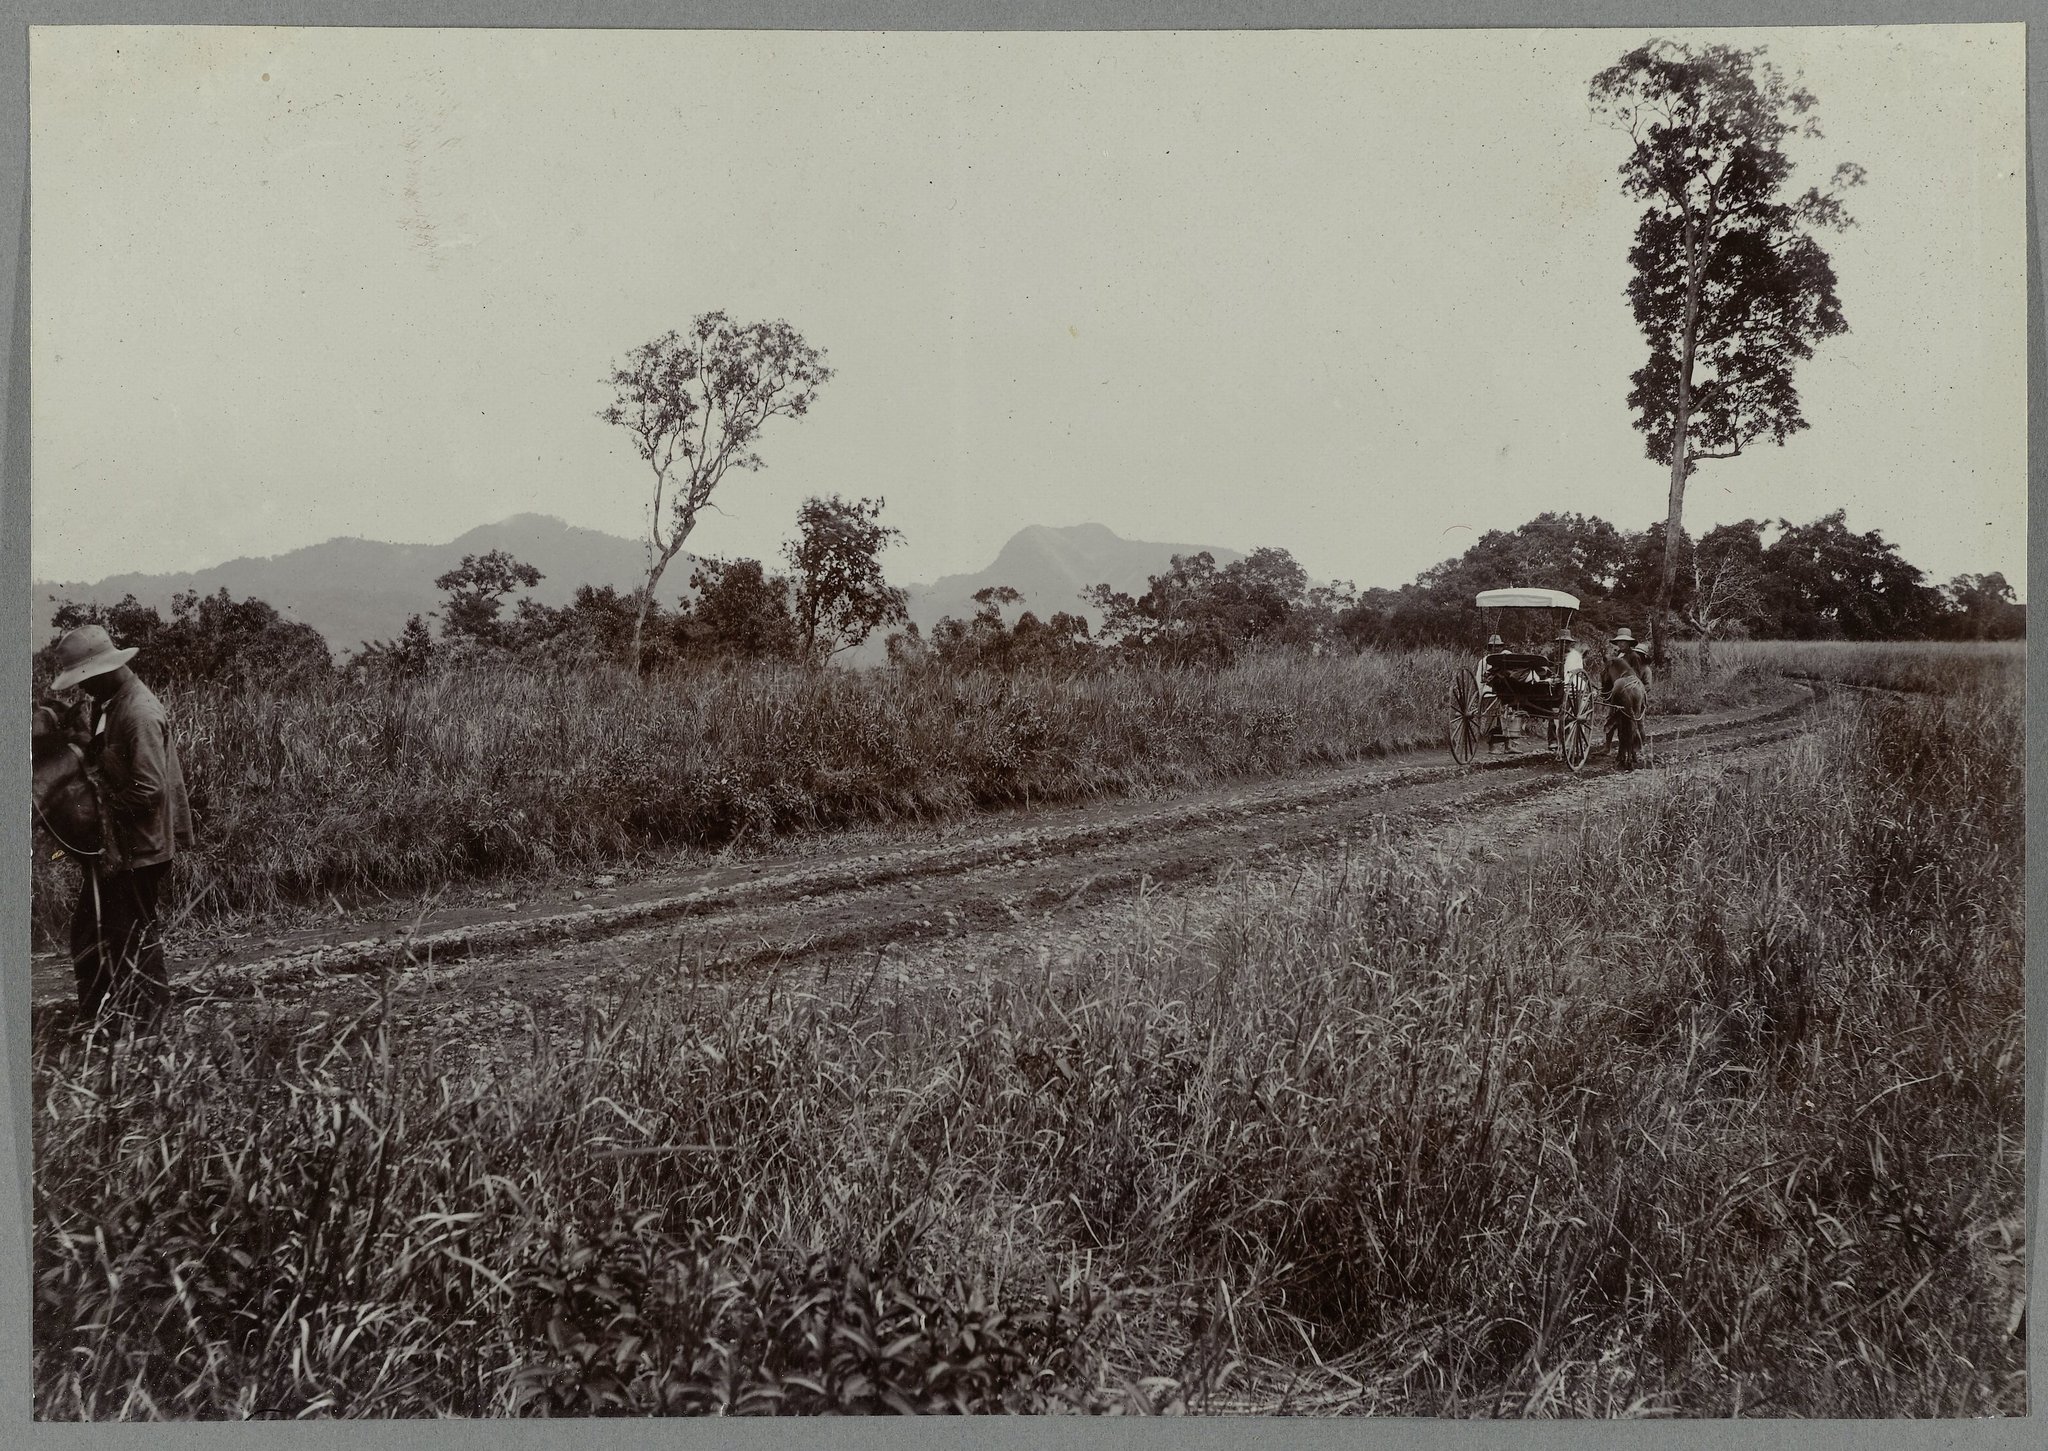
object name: photograph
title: Aanleg van de weg door vlak land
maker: Anonymous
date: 1903-1913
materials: photographic support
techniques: photography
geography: north sumatra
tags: arnhem, albertus dominicus laman trip, building activities, traffic by road or path with motor-vehicle, landscapes in tropical and sub-tropical regions, road, path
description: Na de expedities naar de Gajo- en Alaslanden o.l.v. Van Daalen (eerste tocht in 1901), werd hij in 1903 belast met voorbereiding van permanente vestiging van Nederlands gezag. Aanleg van een weg van de Noordkust naar het binnenland was hierbij van groot belang. Deze zgn. Gajoweg werd aangelegd tussen 1903 en 1914, van Bireuen aan de kust naar Takinguen aan het bergmeer Danau Lauttawar, totale lente 104 km.